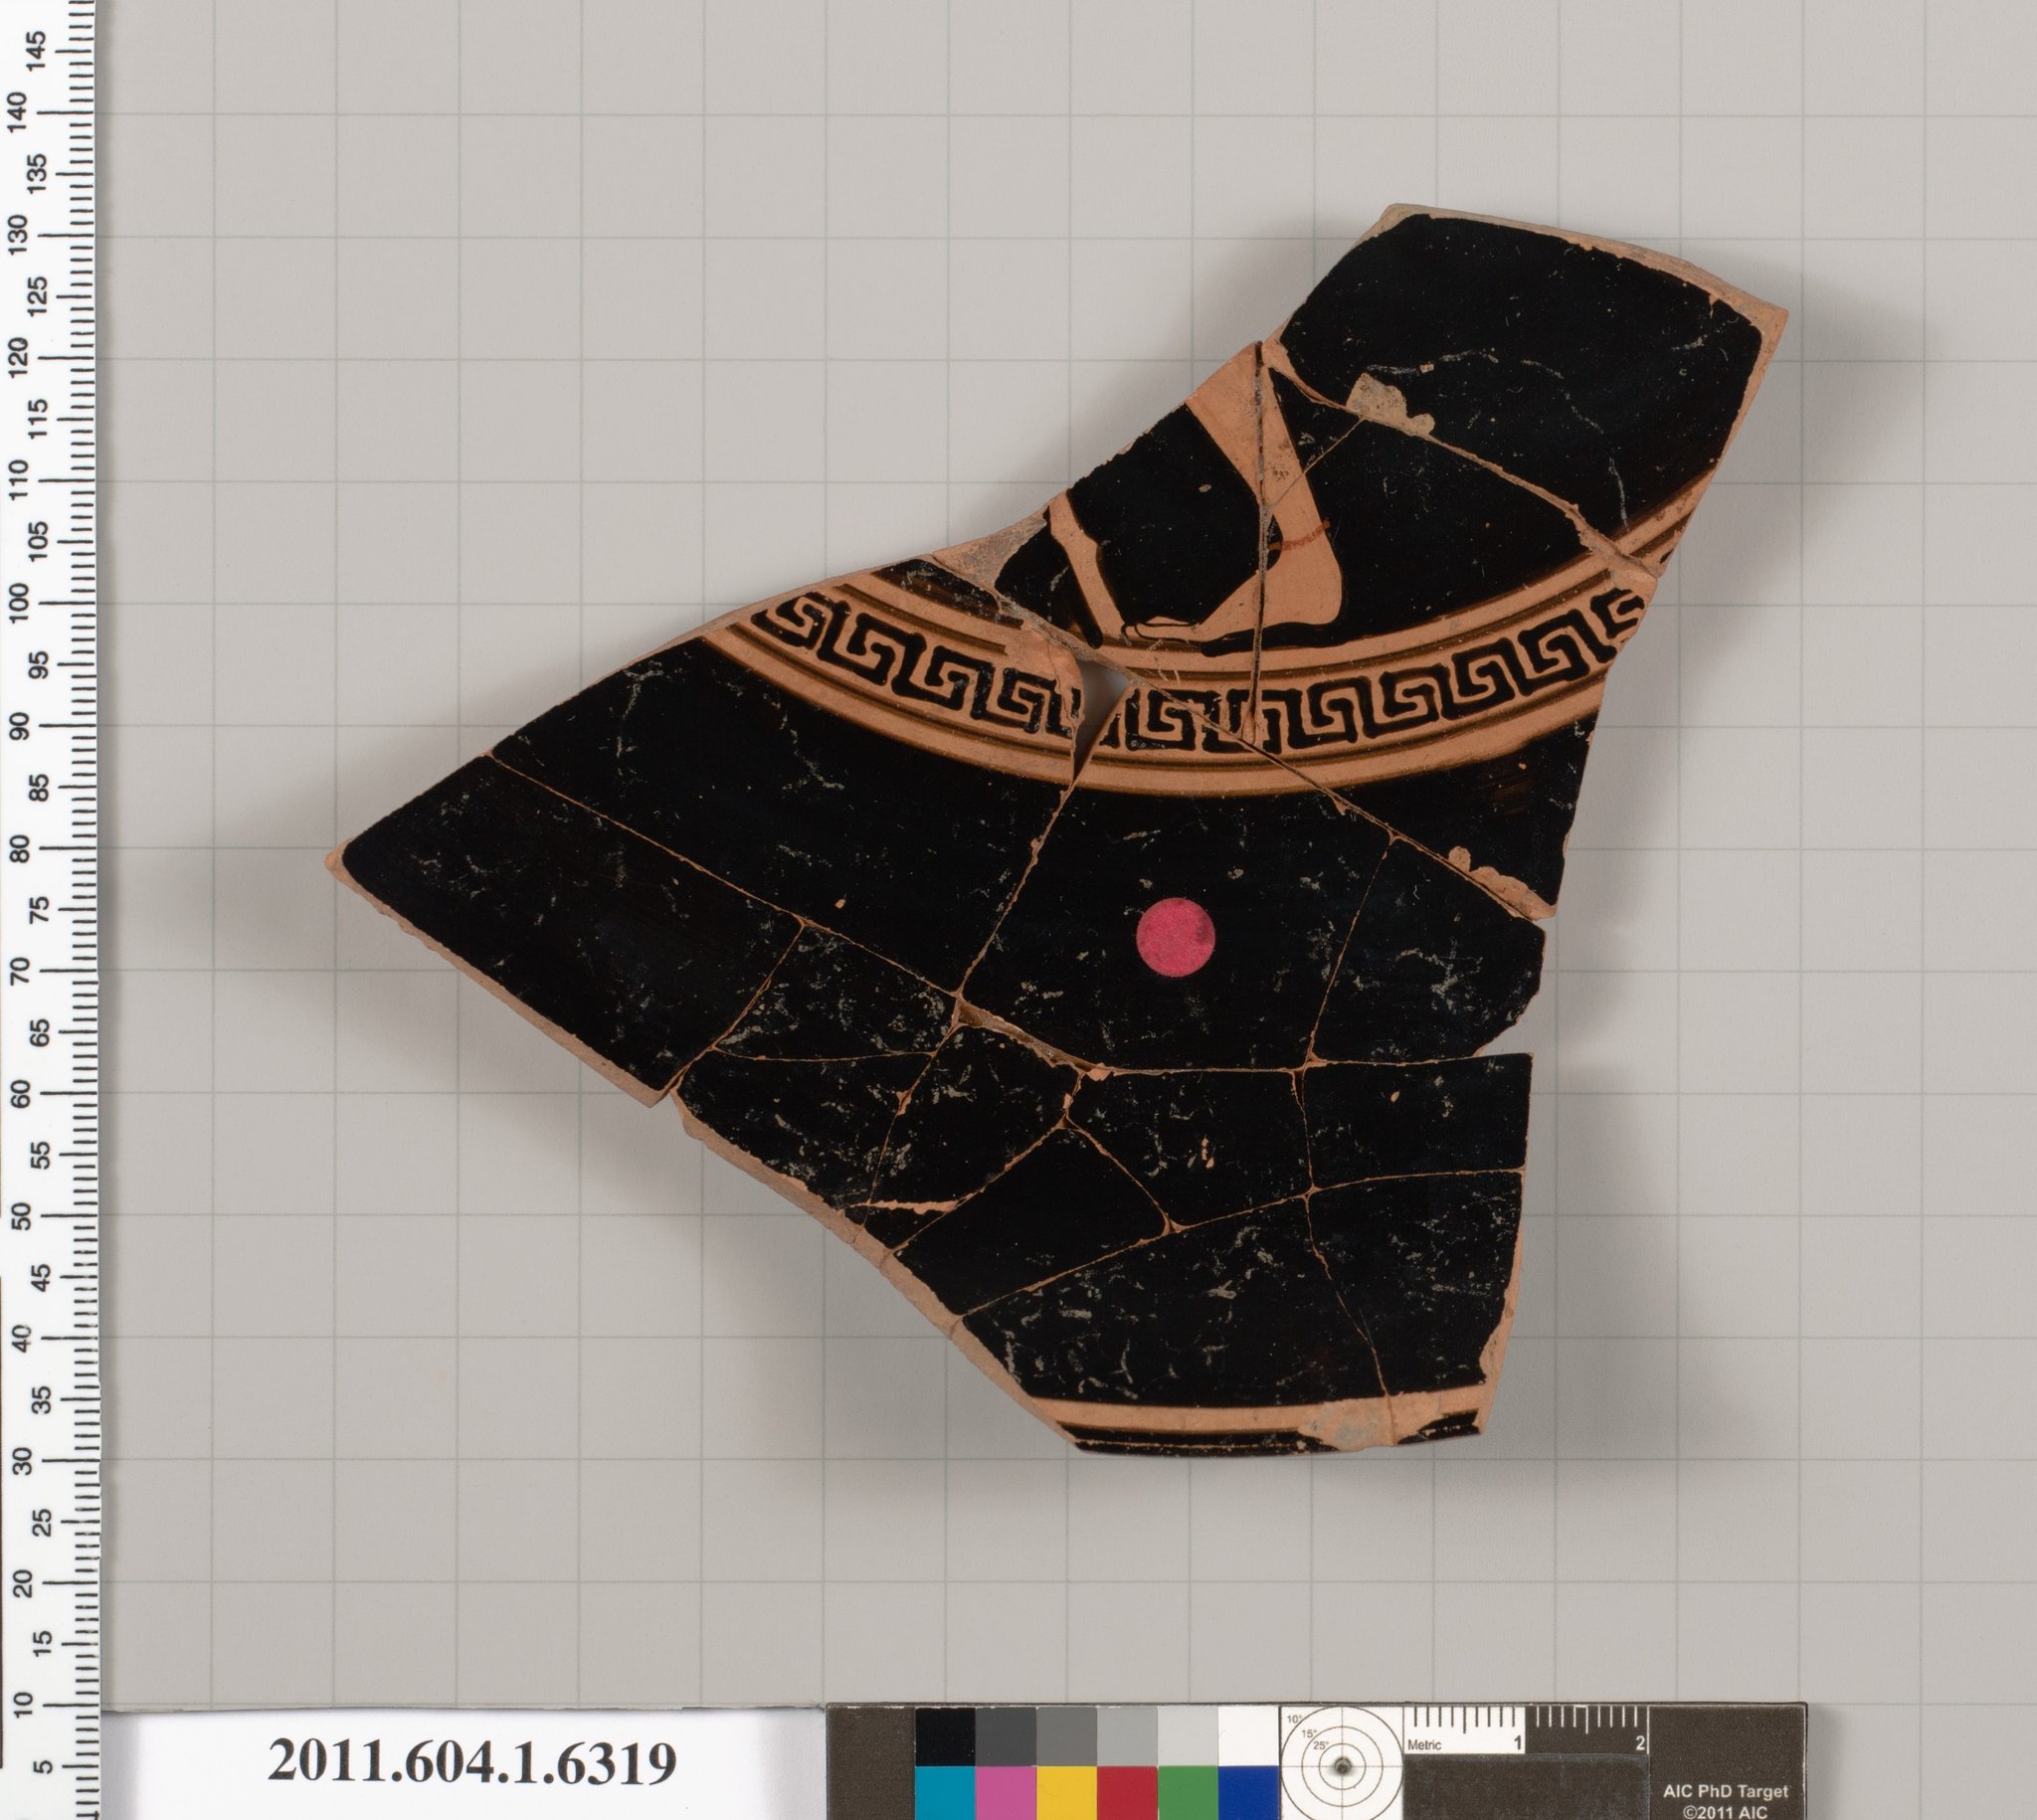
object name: kylix fragment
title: Terracotta fragment of a kylix (drinking cup)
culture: greek, attic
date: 500-480 BCE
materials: terracotta